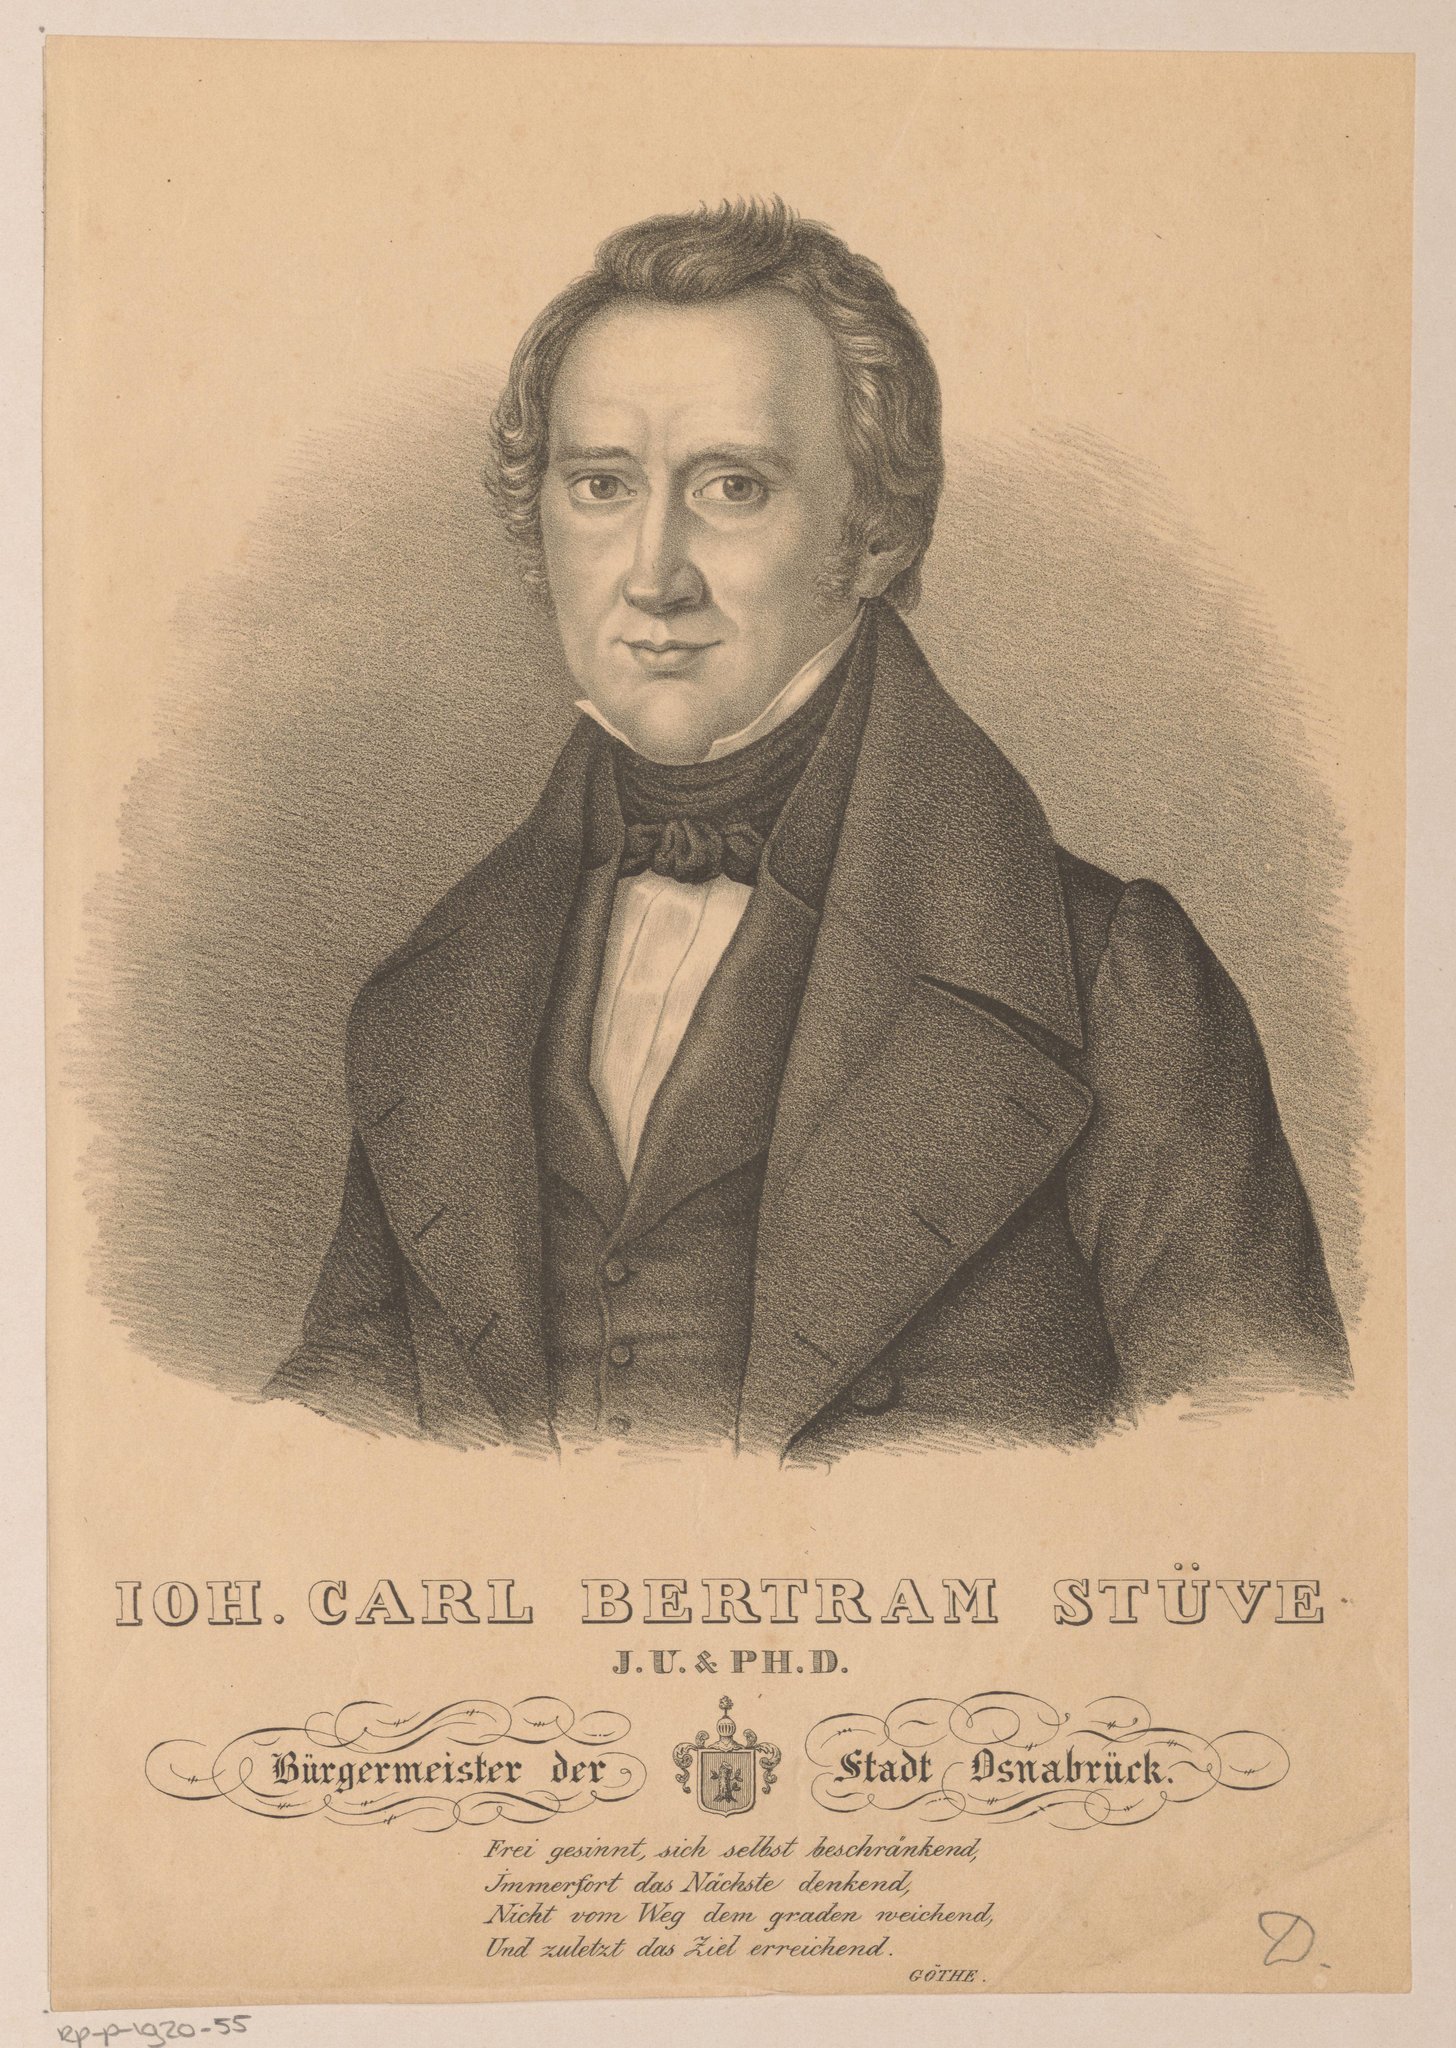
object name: print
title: Portret van Johann Karl Bertram Stüve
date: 1820-1860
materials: paper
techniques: lithograph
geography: germany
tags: mayor, mayor, burgomaster, historical persons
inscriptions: collector's mark: Lugt 2228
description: Met onder het portret een vierregelig gedicht in het Duits.